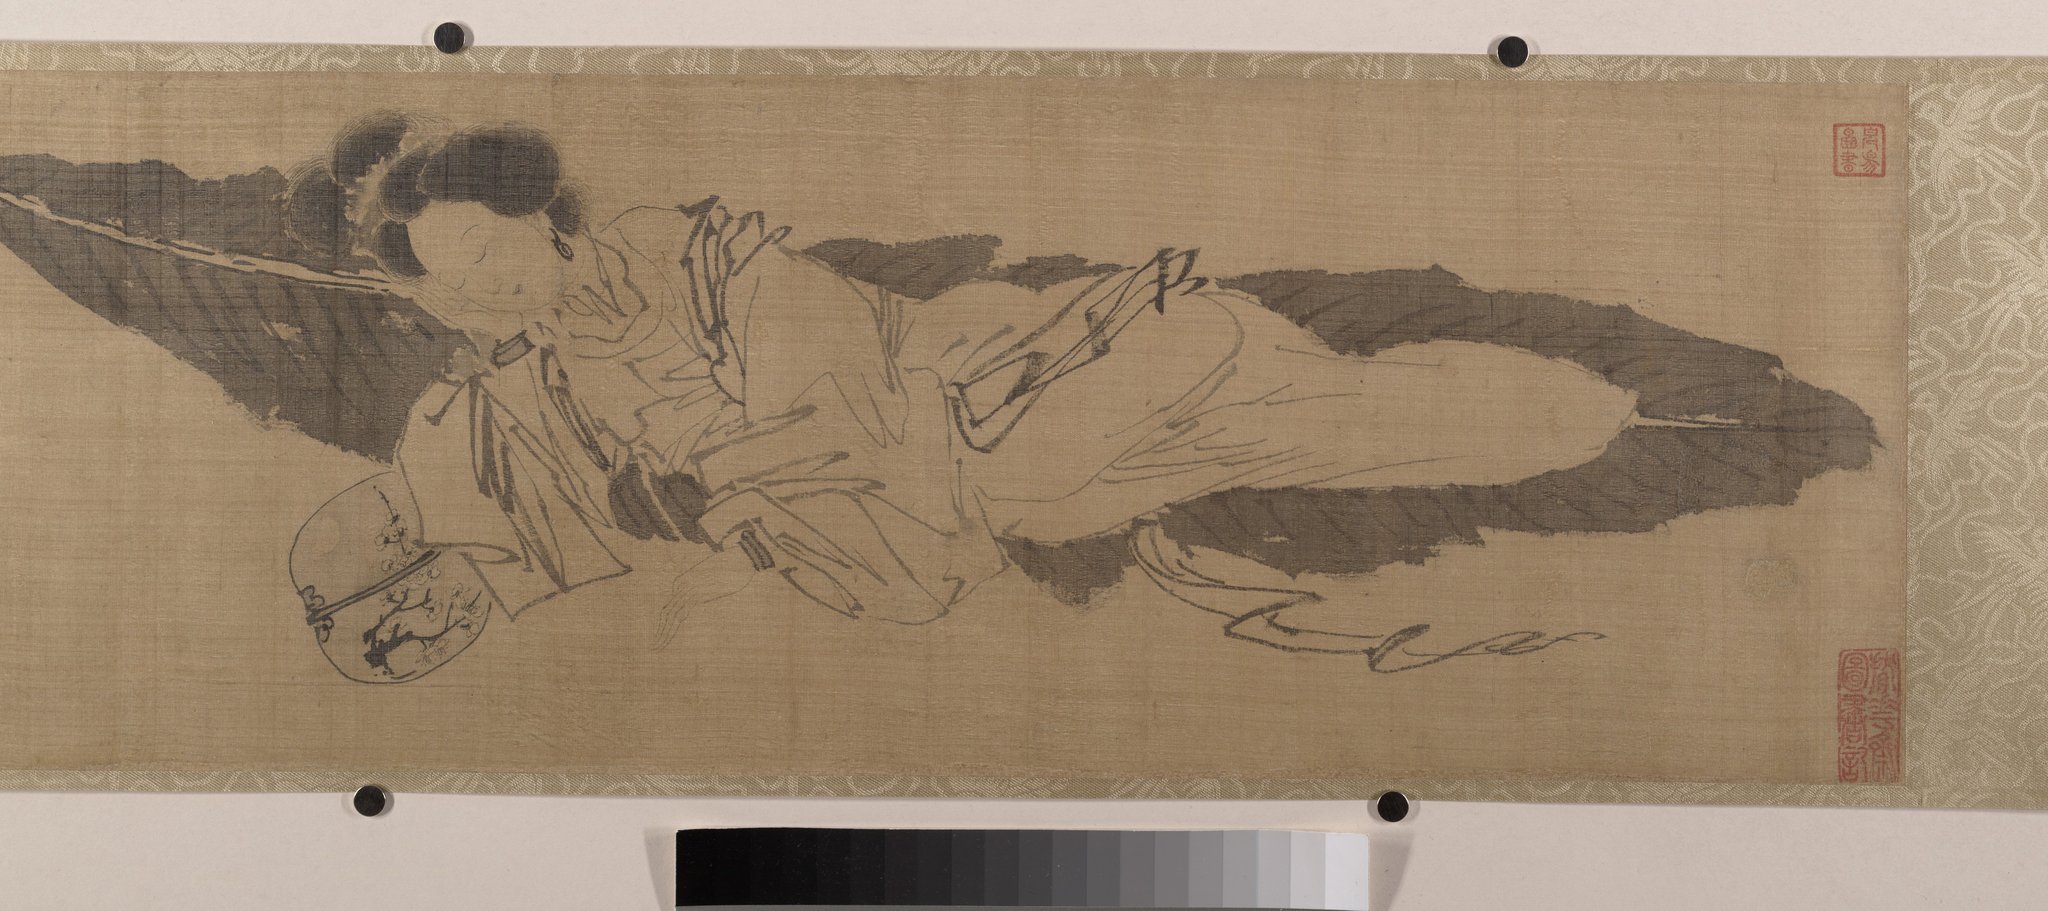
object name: handscroll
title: Beauty Sleeping on a Banana Leaf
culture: chinese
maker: tang yin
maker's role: artist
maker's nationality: chinese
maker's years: 1470-1524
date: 1470-1524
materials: ink, silk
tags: sleeping,women